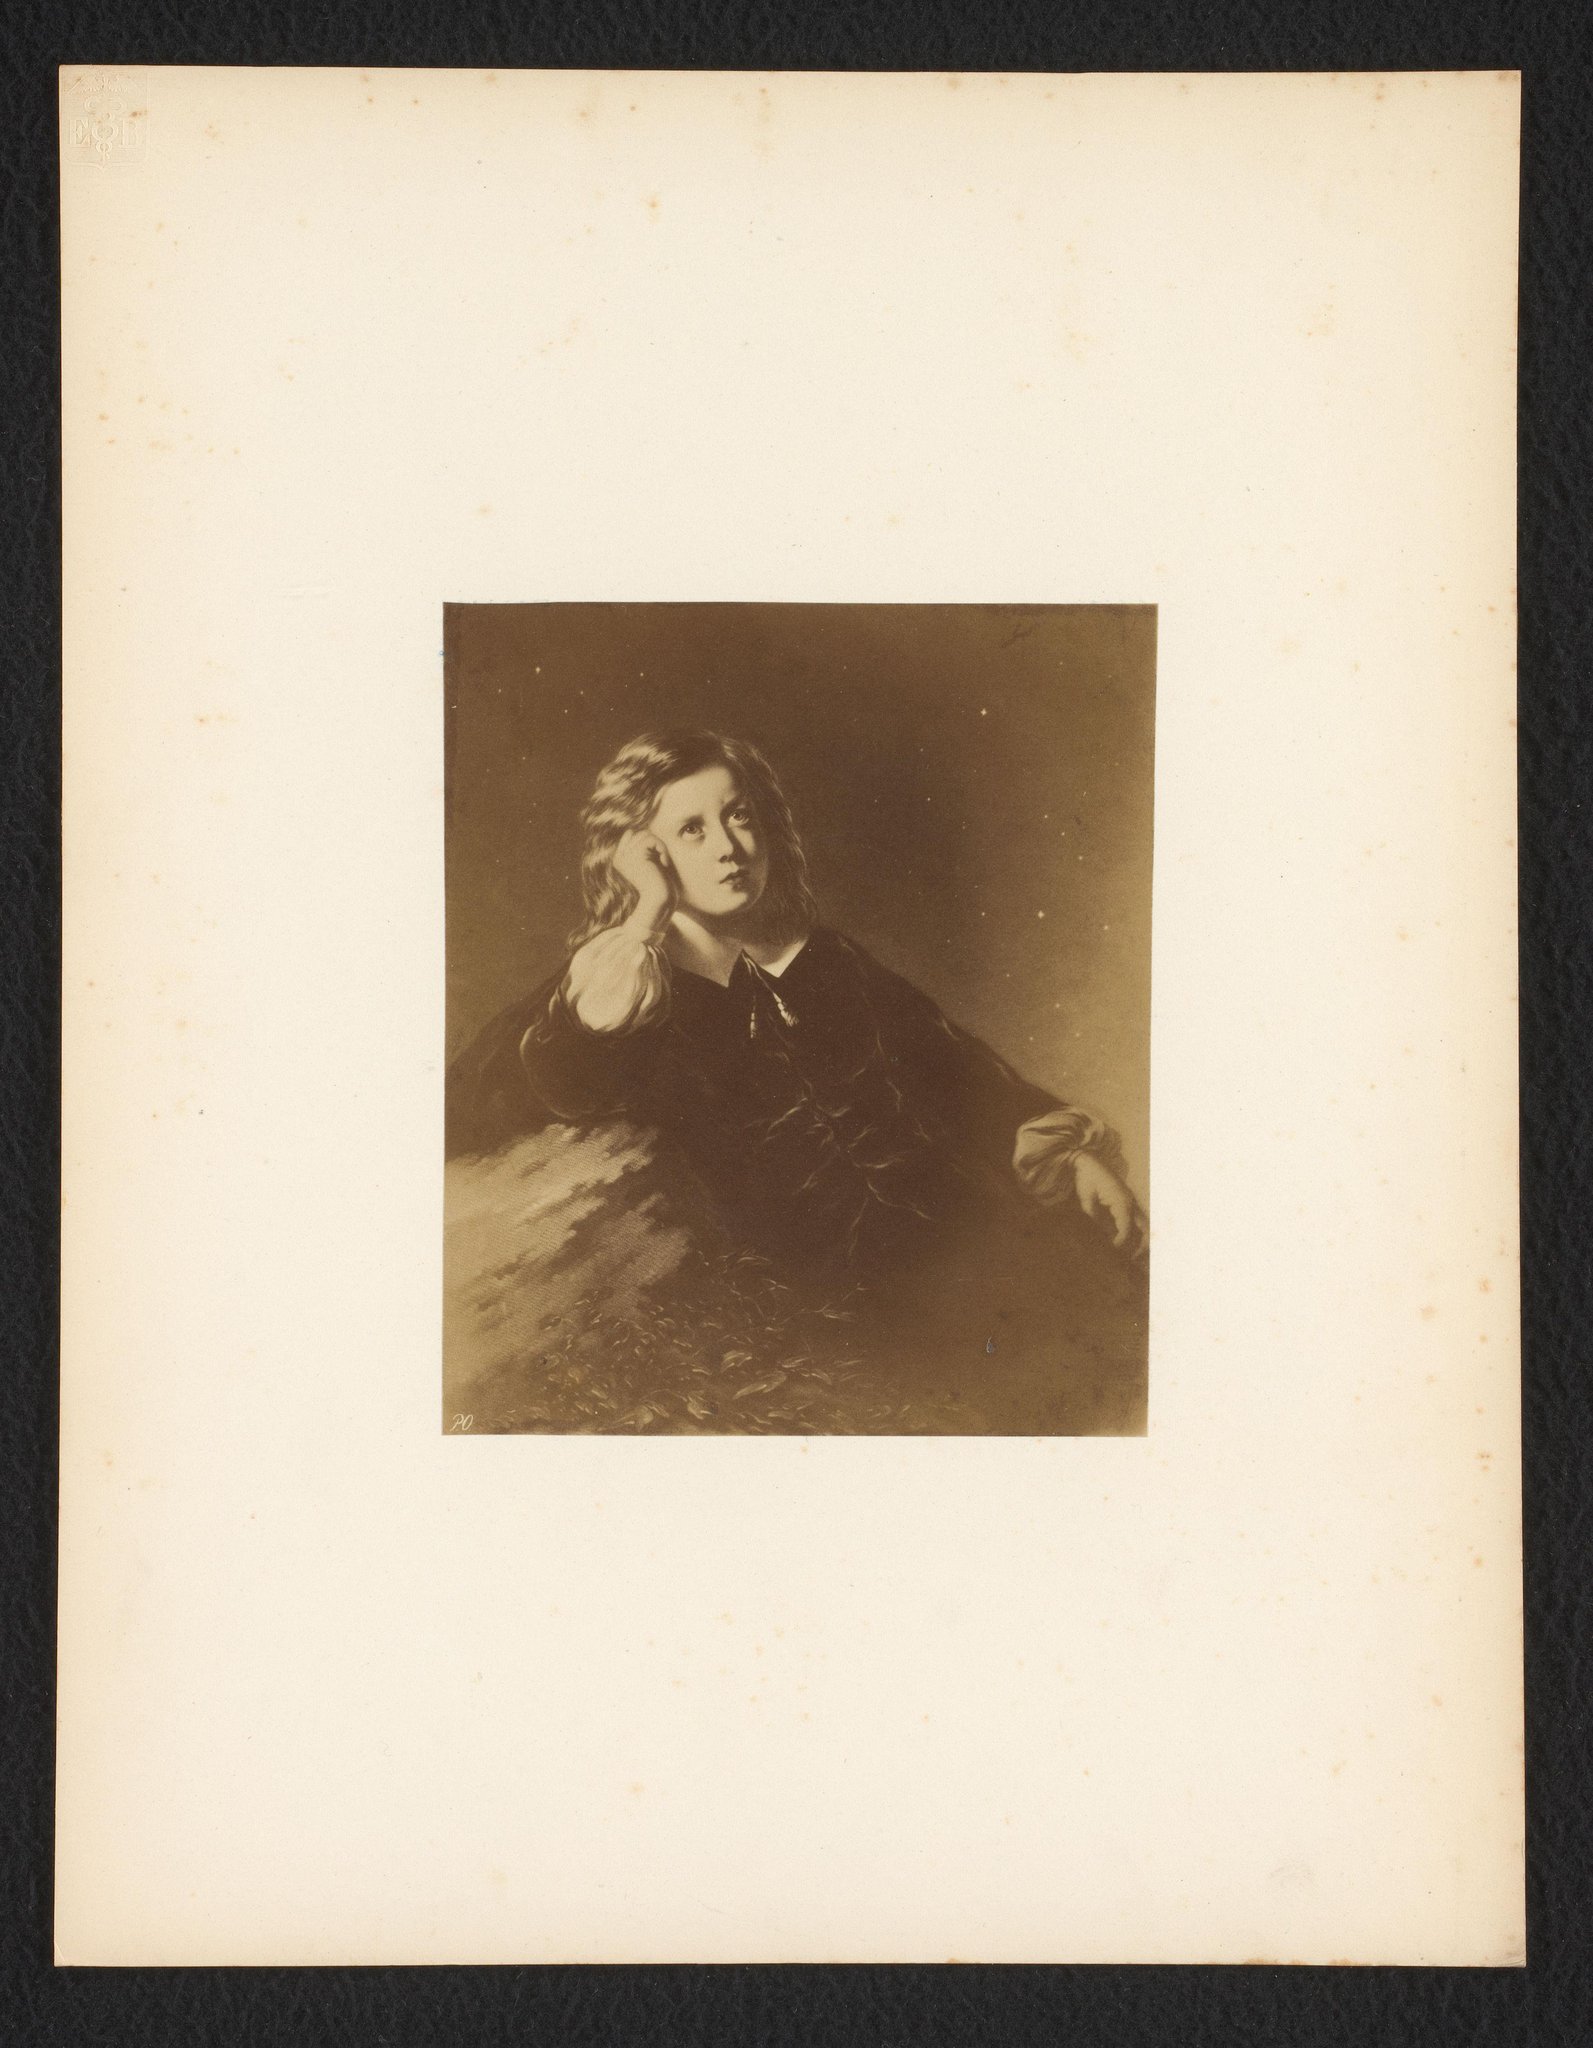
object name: photograph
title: Fotoreproductie van het schilderij Isaac Newton at the Age of Twelve naar Frederich Newenham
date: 1860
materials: cardboard, paper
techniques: albumen print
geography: amsterdam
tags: london, physicist, picture, painting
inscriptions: monogram: ‘P.O.’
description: Deze foto maakt deel uit van een omslag.